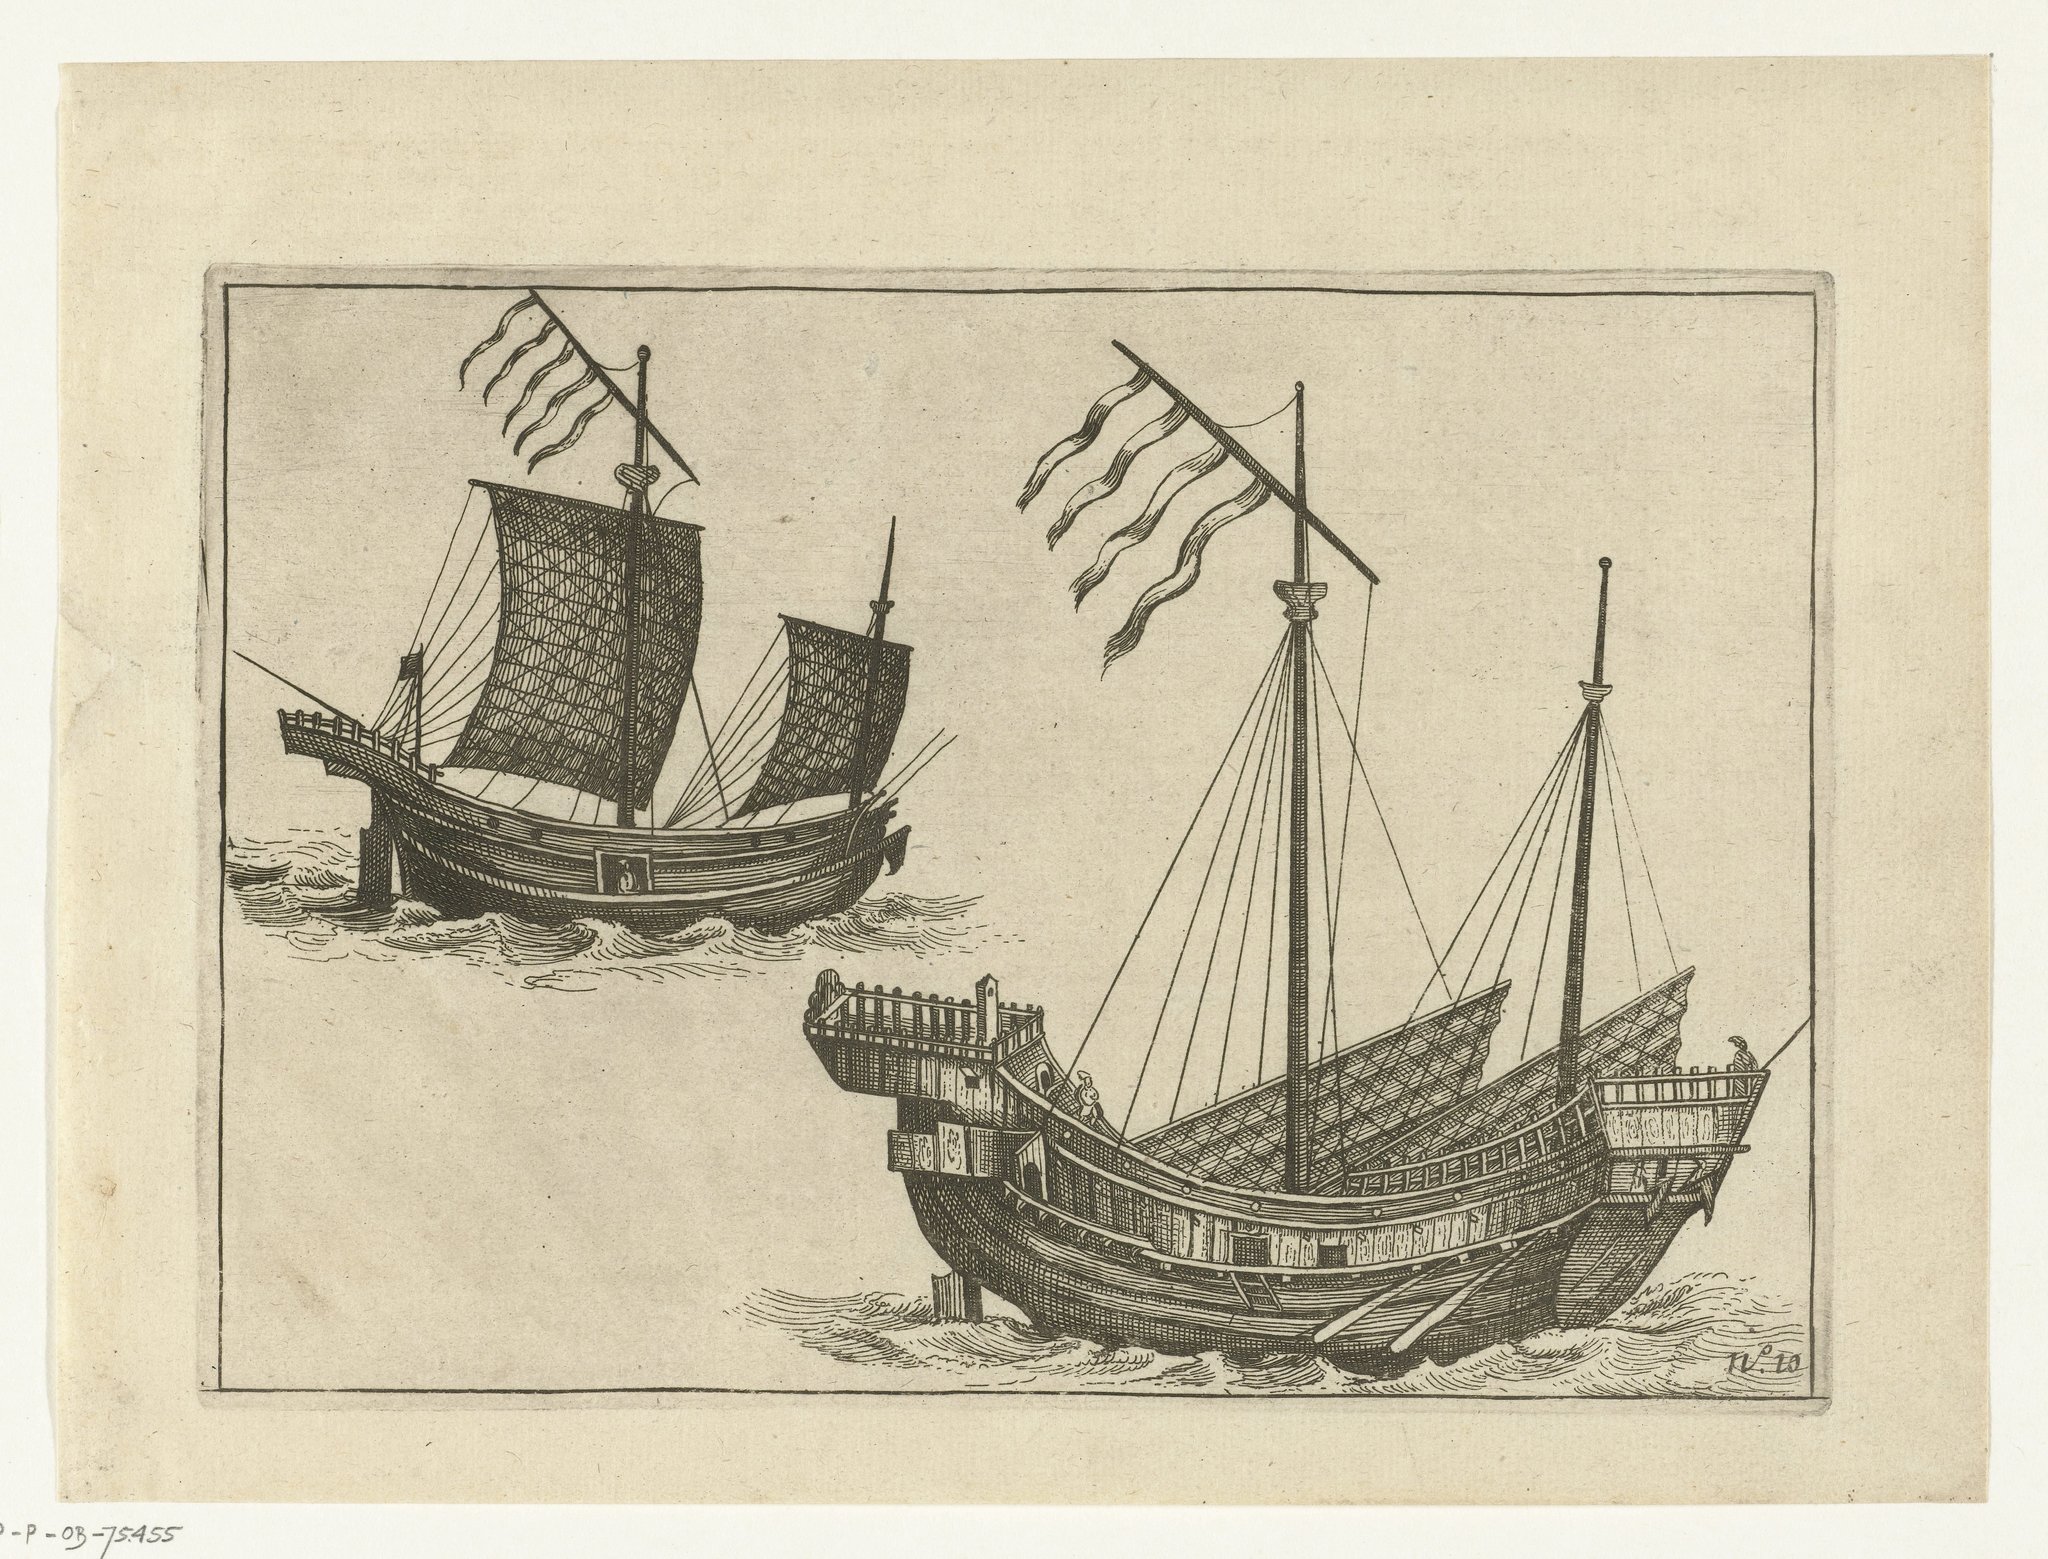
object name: print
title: Afteeckeninghe van de Chinesche Joncken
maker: Anonymous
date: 1644-1646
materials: paper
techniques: etching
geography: northern netherlands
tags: rotterdam, mayor, ships (in general) (+ propulsion of vehicle, ship, etc. by wind), landscapes in tropical and sub-tropical regions, exploration, expedition, voyage of discovery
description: Gebruikt als illustratie: Historisch Verhael Vande treffelijcke Reyse, gedaen naer de Oost-Indien ende China, met elf Schepen. Door den Manhaften Admirael Cornelis Matelief de Jonge. Inden Jaren 1605. 1606. 1607. ende 1608. Deze tekst opgenomen in : I. Commelin, Begin ende voortgangh, van de Vereenighde Nederlantsche Geoctroyeerde Oost-Indische Compagnie, J. Janssonius, Amsterdam 1646. Genummerd: No. 10.